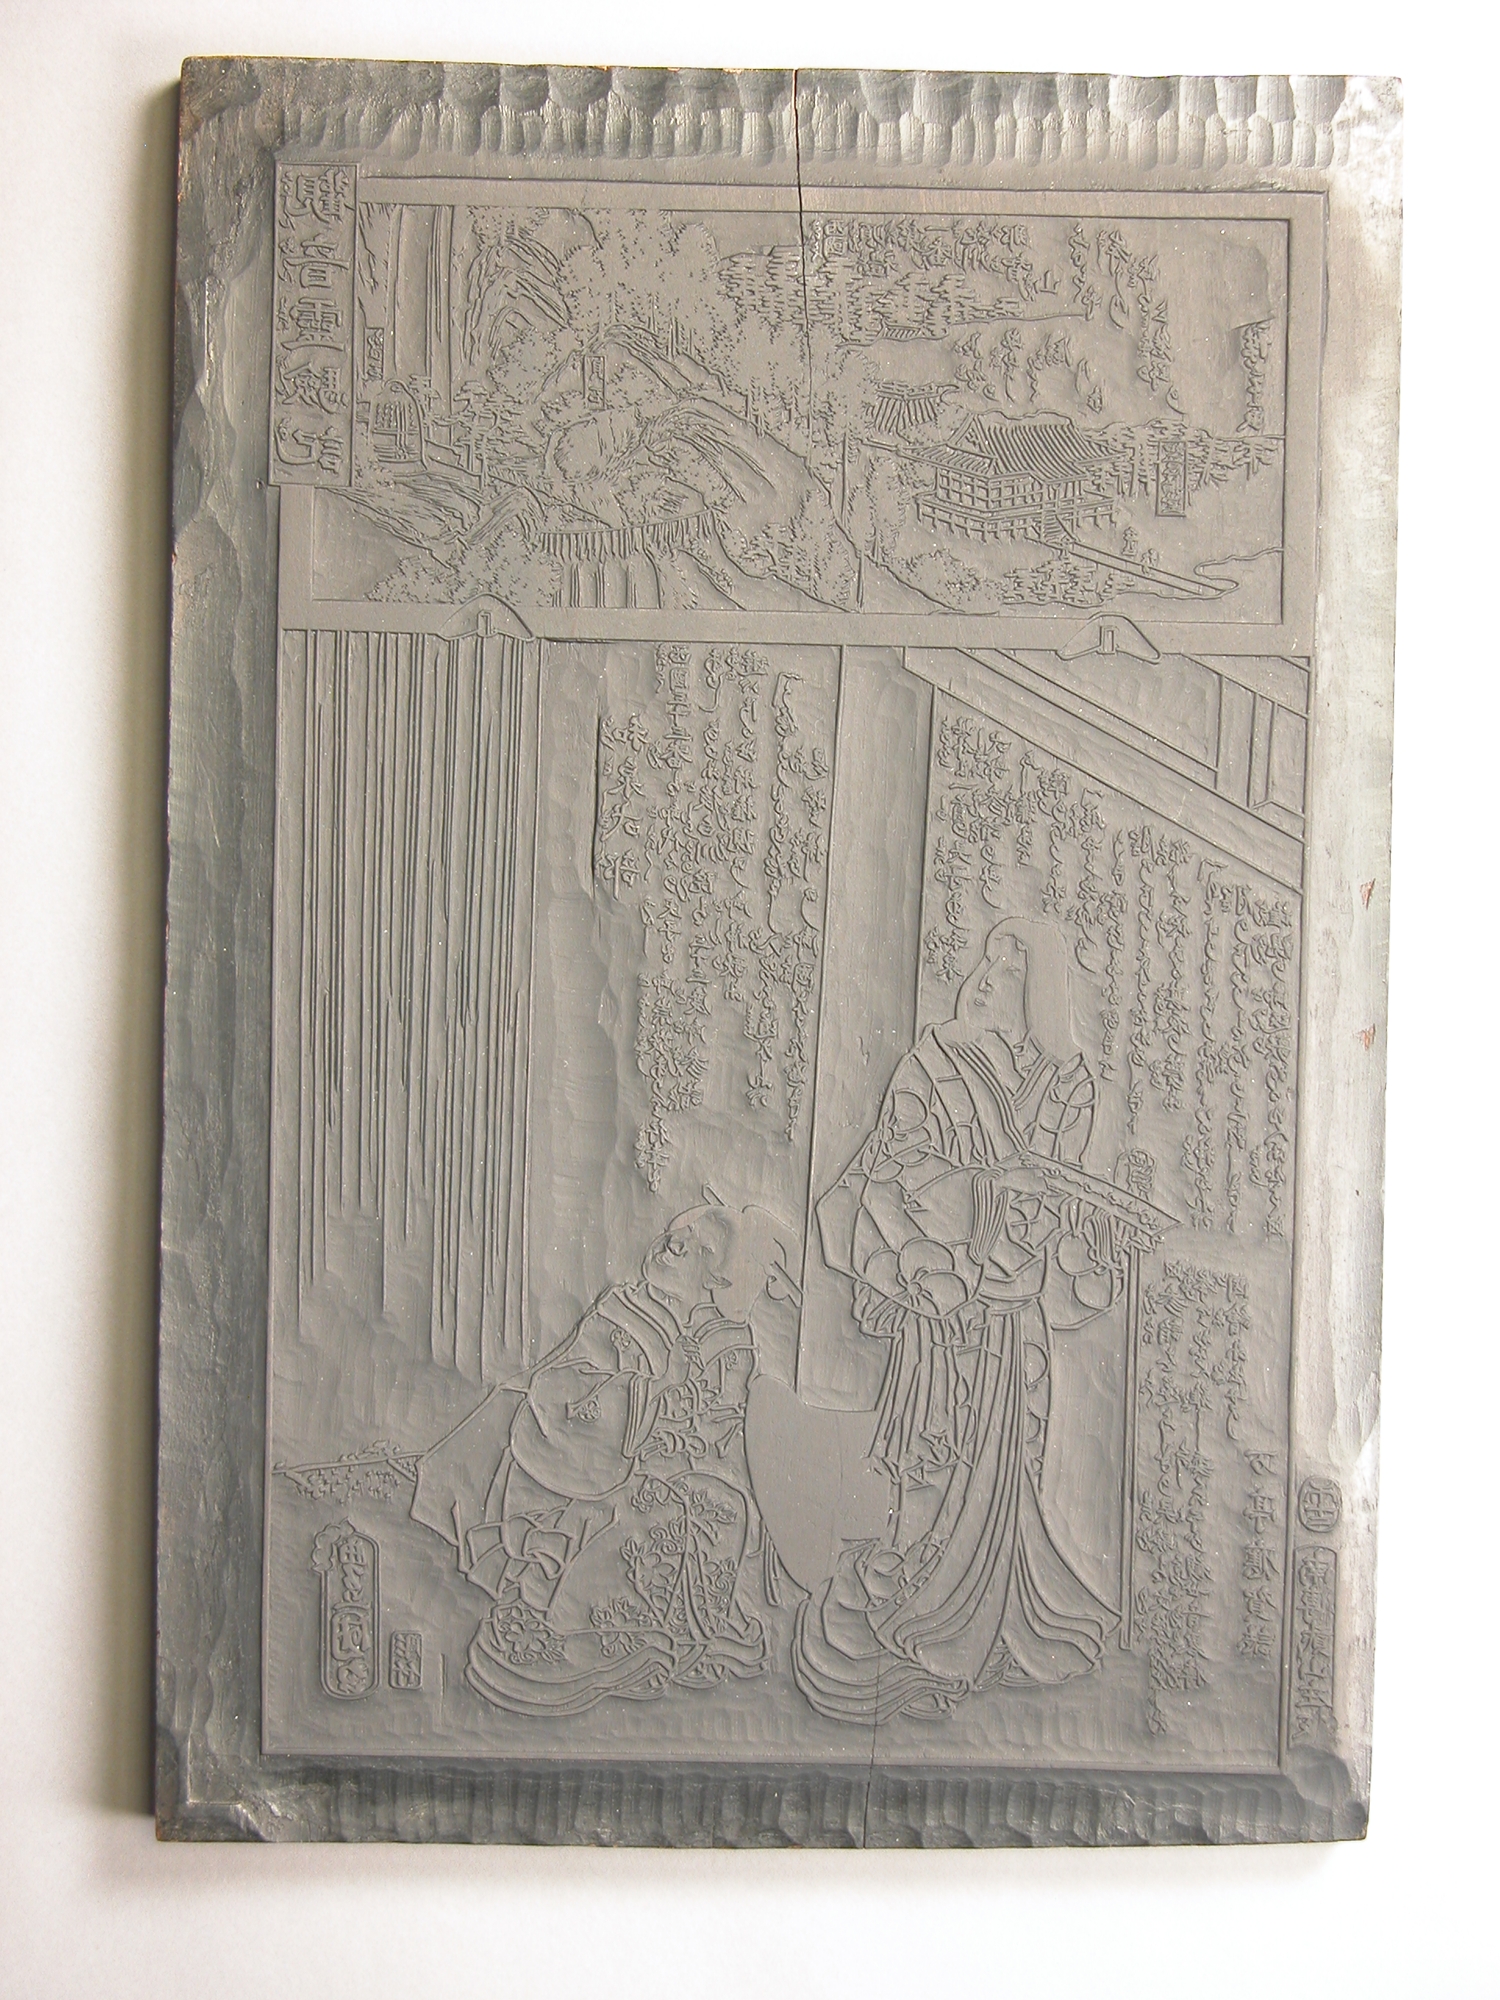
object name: printer's woodblock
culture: japanese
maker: utagawa toyokuni i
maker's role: artist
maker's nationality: japanese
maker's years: 1769-1825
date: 1701-1900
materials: wood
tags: women,landscapes